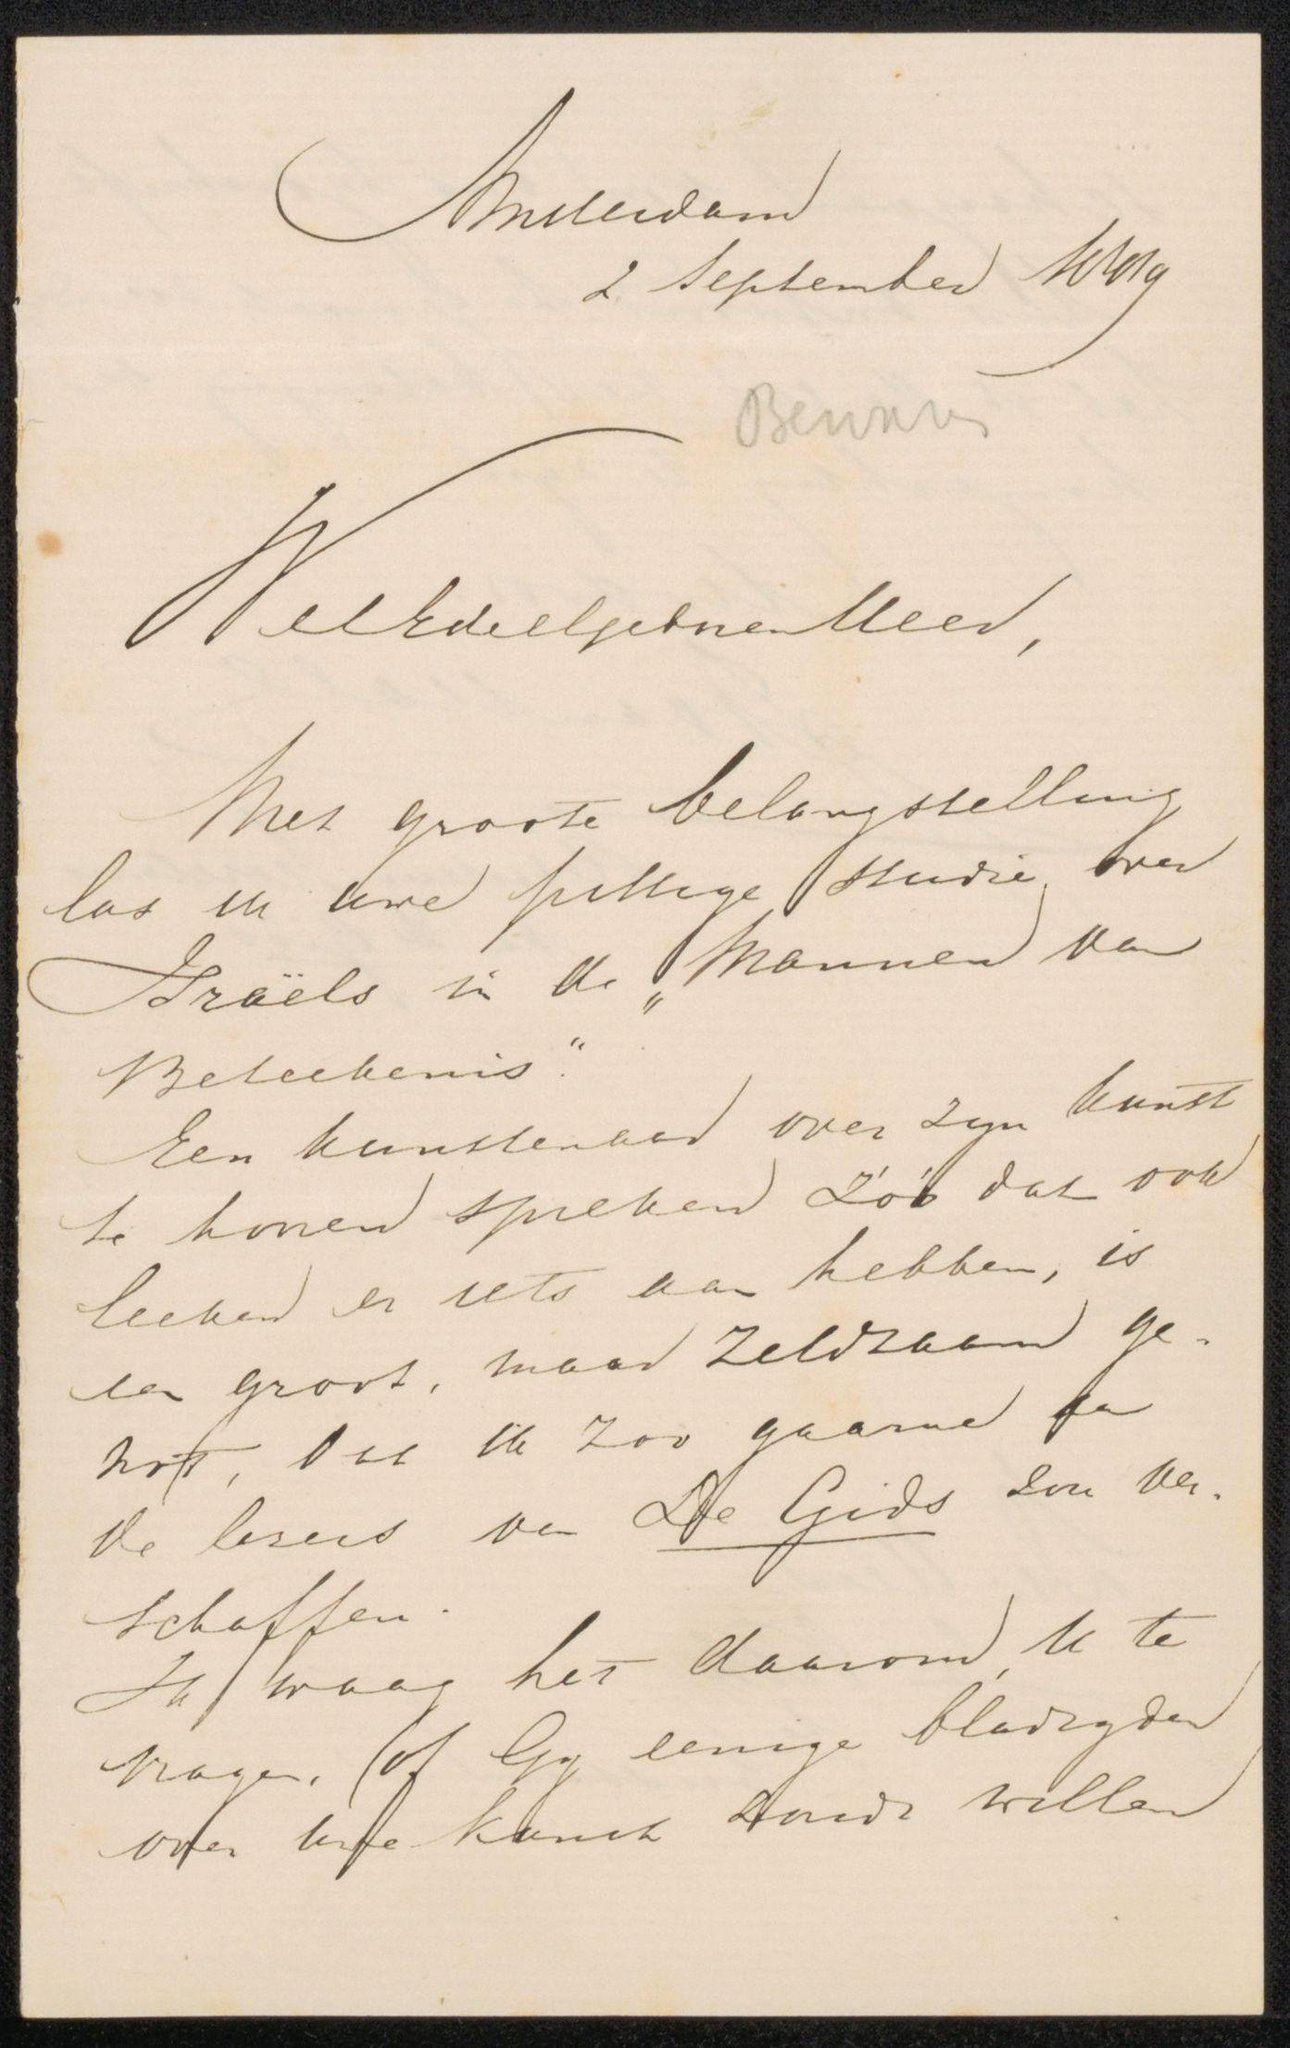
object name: letter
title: Brief aan Jan Veth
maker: jacob nicolaas van hall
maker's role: politician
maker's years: 1840-1918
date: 1889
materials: ink, paper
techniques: pen, writing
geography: amsterdam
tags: the hague, jozef israëls, dordrecht, amsterdam, painter, print maker, draughtsman, designer, jan veth, printed matter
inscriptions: watermark, collector's mark: ‘RPK’